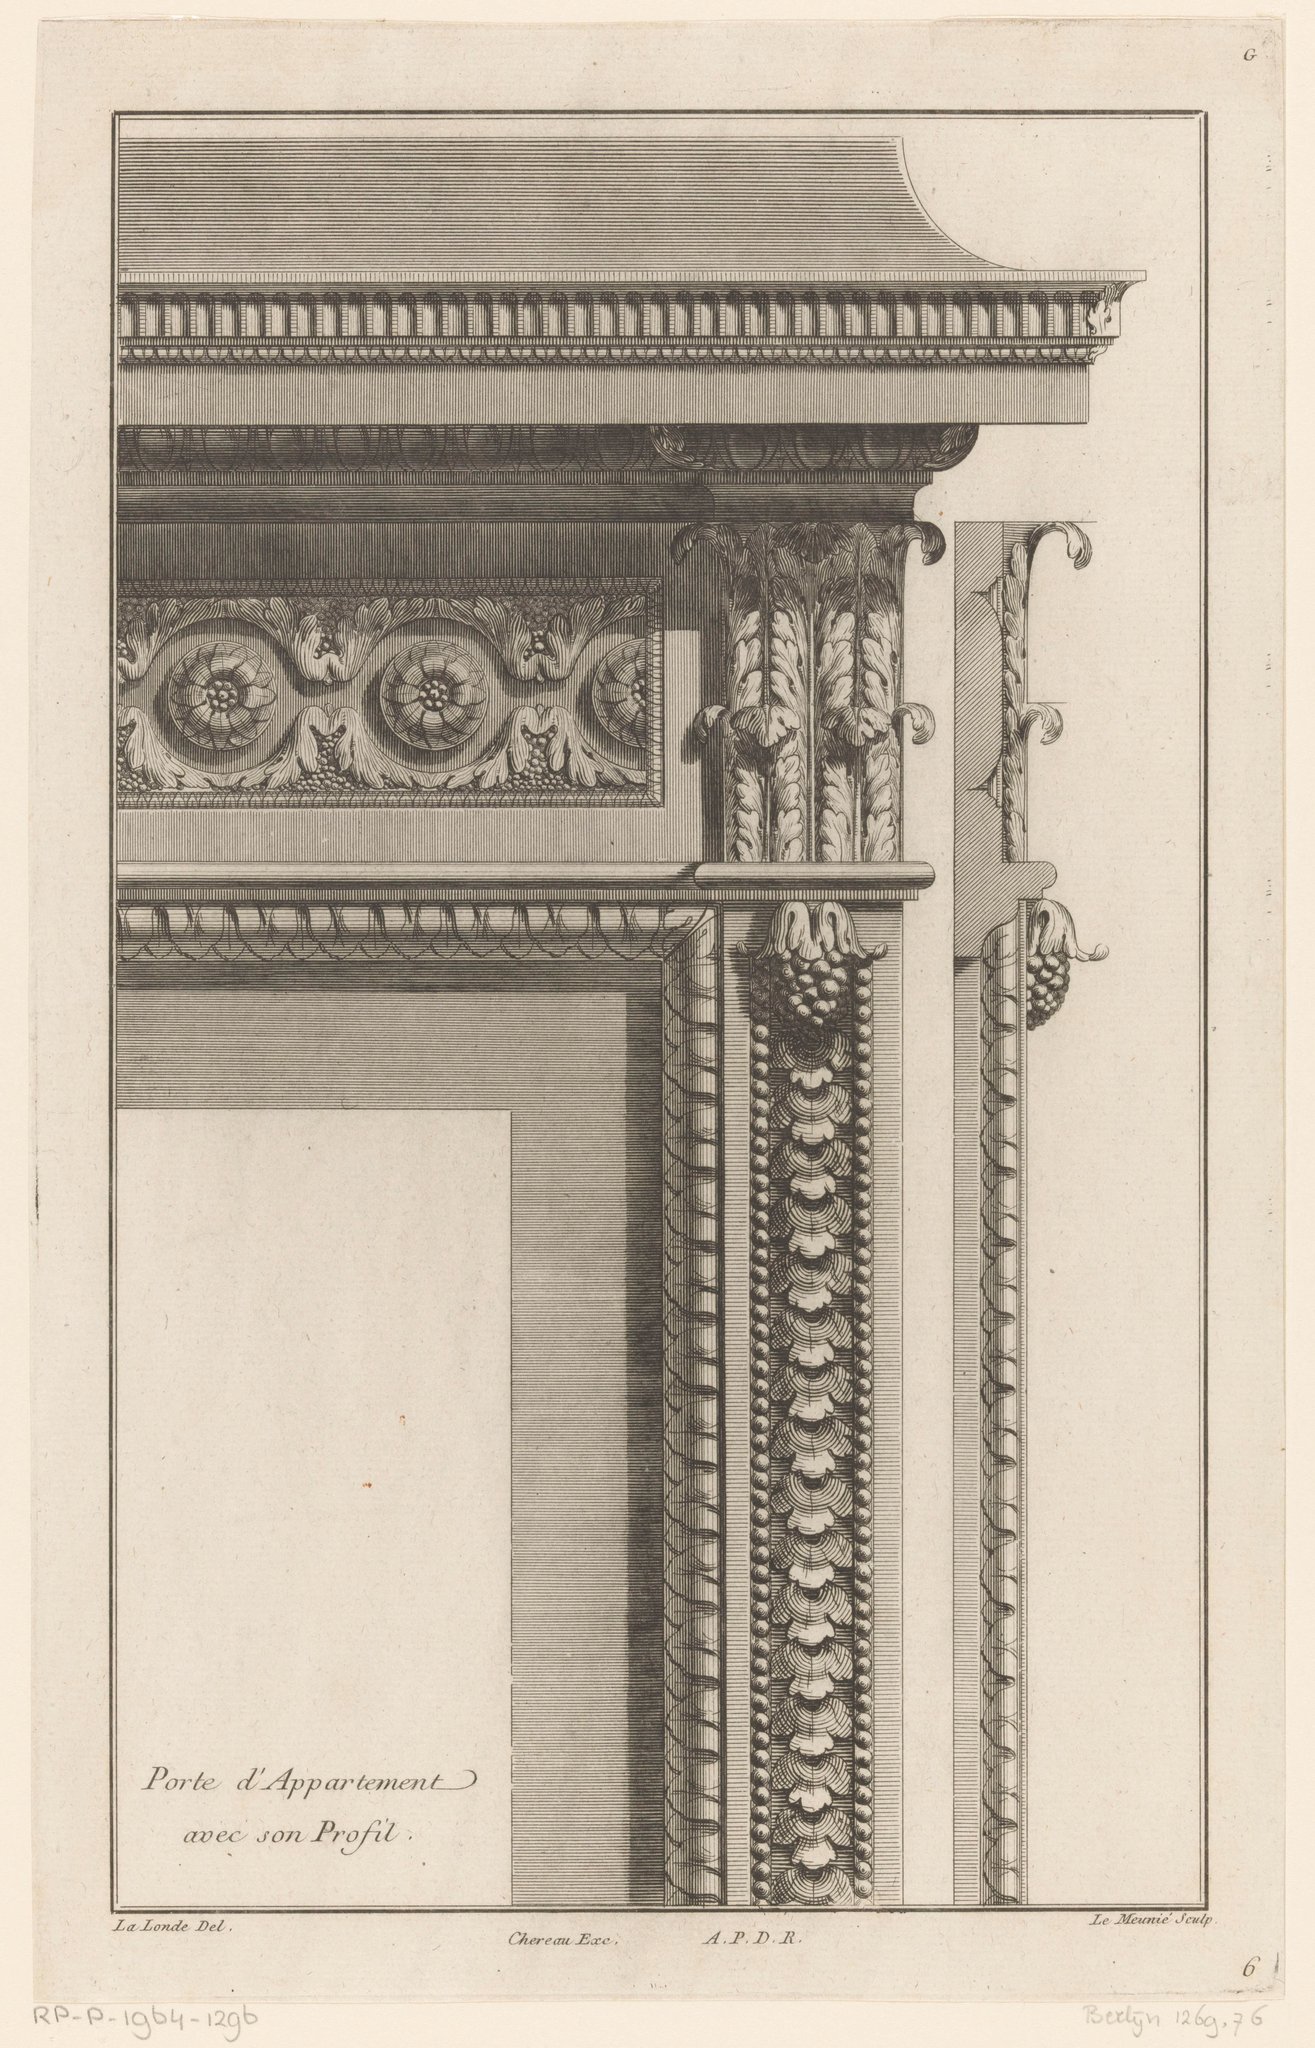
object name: ornament print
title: Porte d'Appartement avec son Profil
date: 1784-1785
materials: paper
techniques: engraving, etching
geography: paris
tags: ornaments ~ art (+ framing decorations), door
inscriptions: collector's mark: Lugt 2228, collector's mark: Lugt 2760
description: Vooraanzicht en profiel van een geornamenteerde deurlijst met bloemmotieven, acanthusbladeren en druiventrossen.